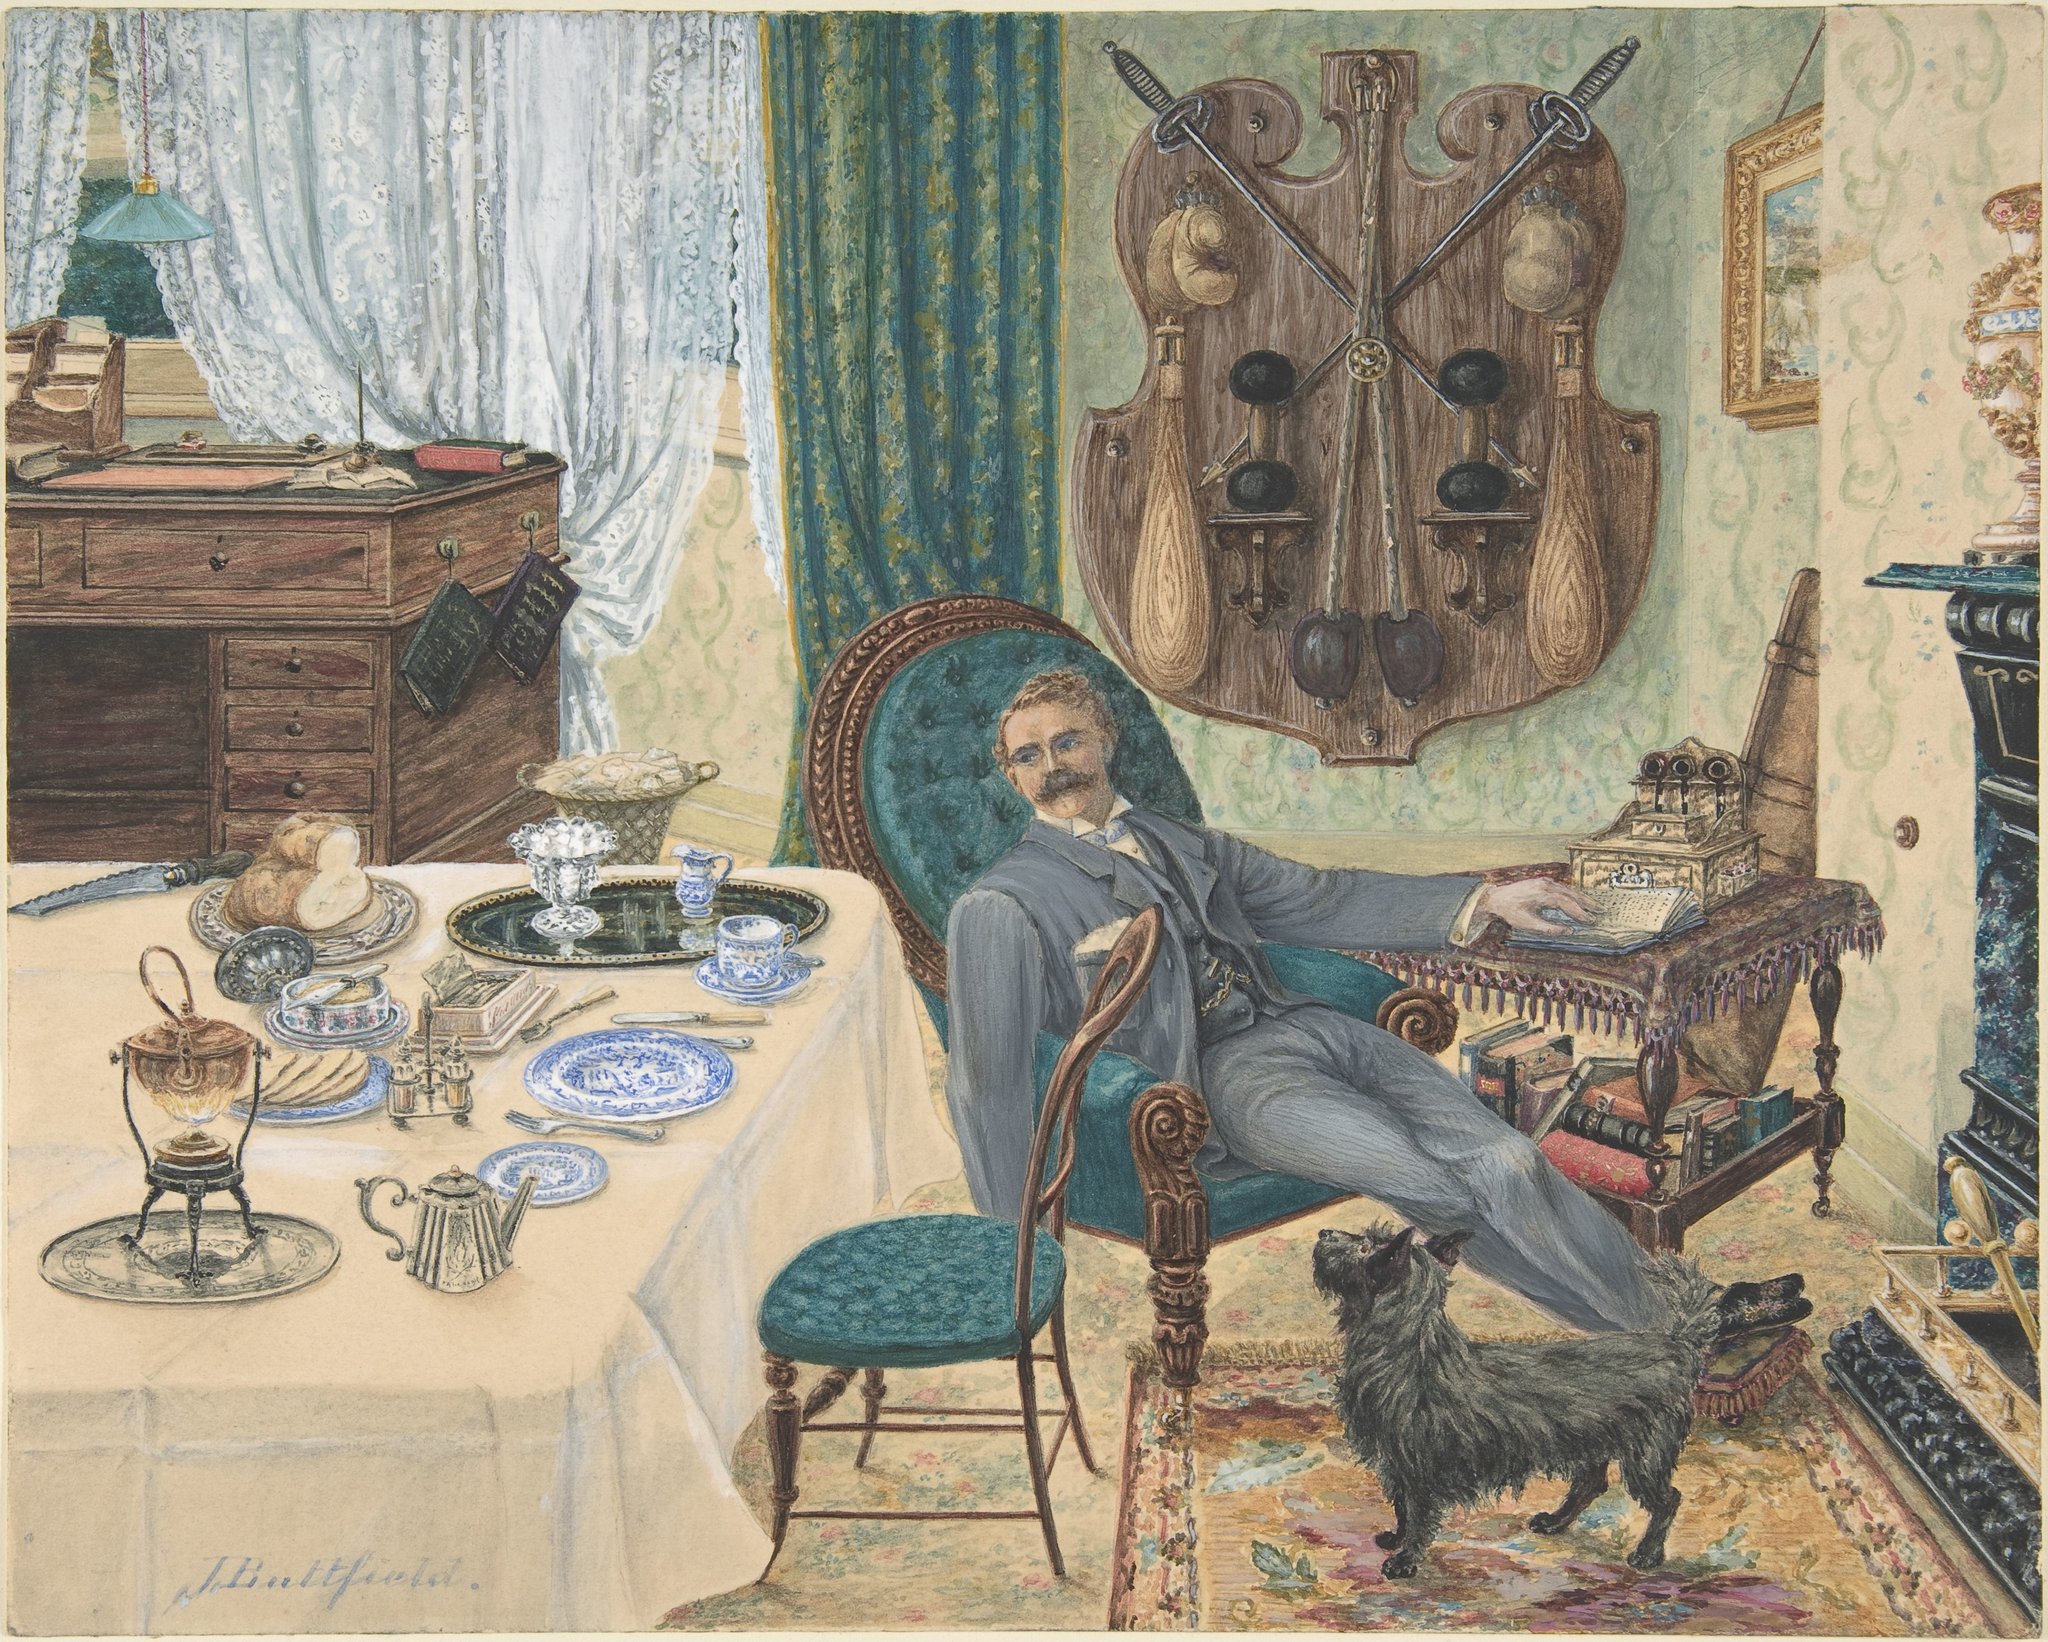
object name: drawing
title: A Bachelor in His Study (The Sportsman's Breakfast)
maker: j. buttfield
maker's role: artist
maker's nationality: british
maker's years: 1850-1900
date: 1867-1900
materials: watercolor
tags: food,interiors,men,dogs,chairs,tables